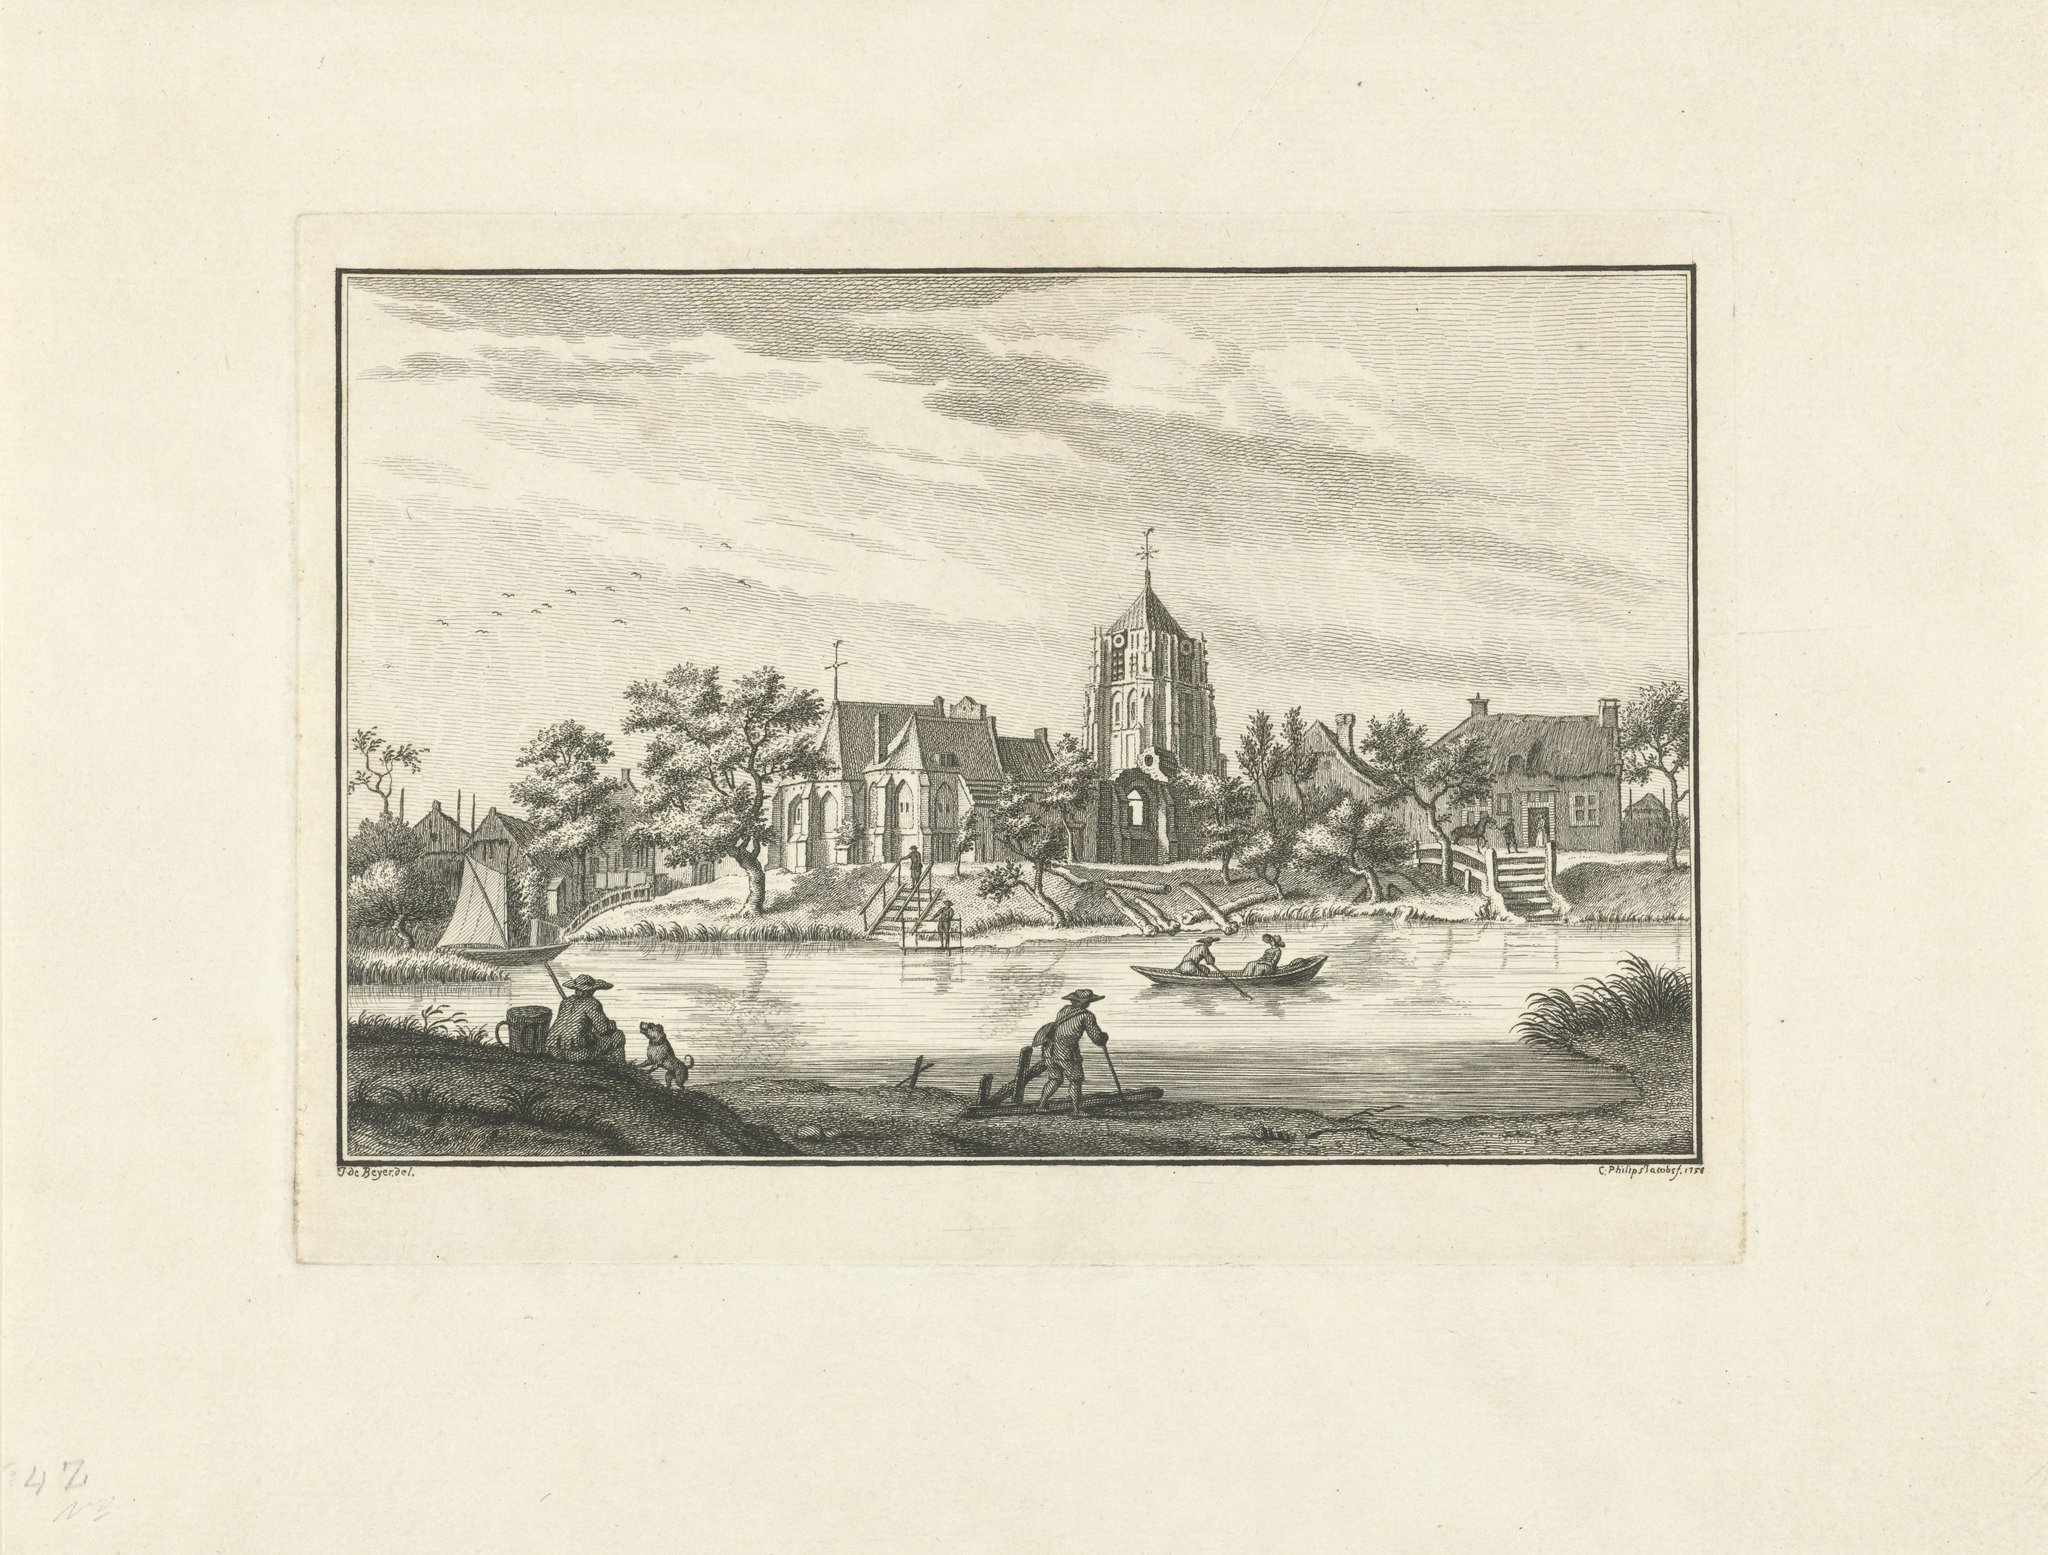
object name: print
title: Gezicht op Acquoy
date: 1758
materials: paper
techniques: etching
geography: amsterdam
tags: city-view in general; 'veduta'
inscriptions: collector's mark: Lugt 2228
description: Gezicht op het dorp Acquoy, aan de rivier de Linge. Met een lege marge.